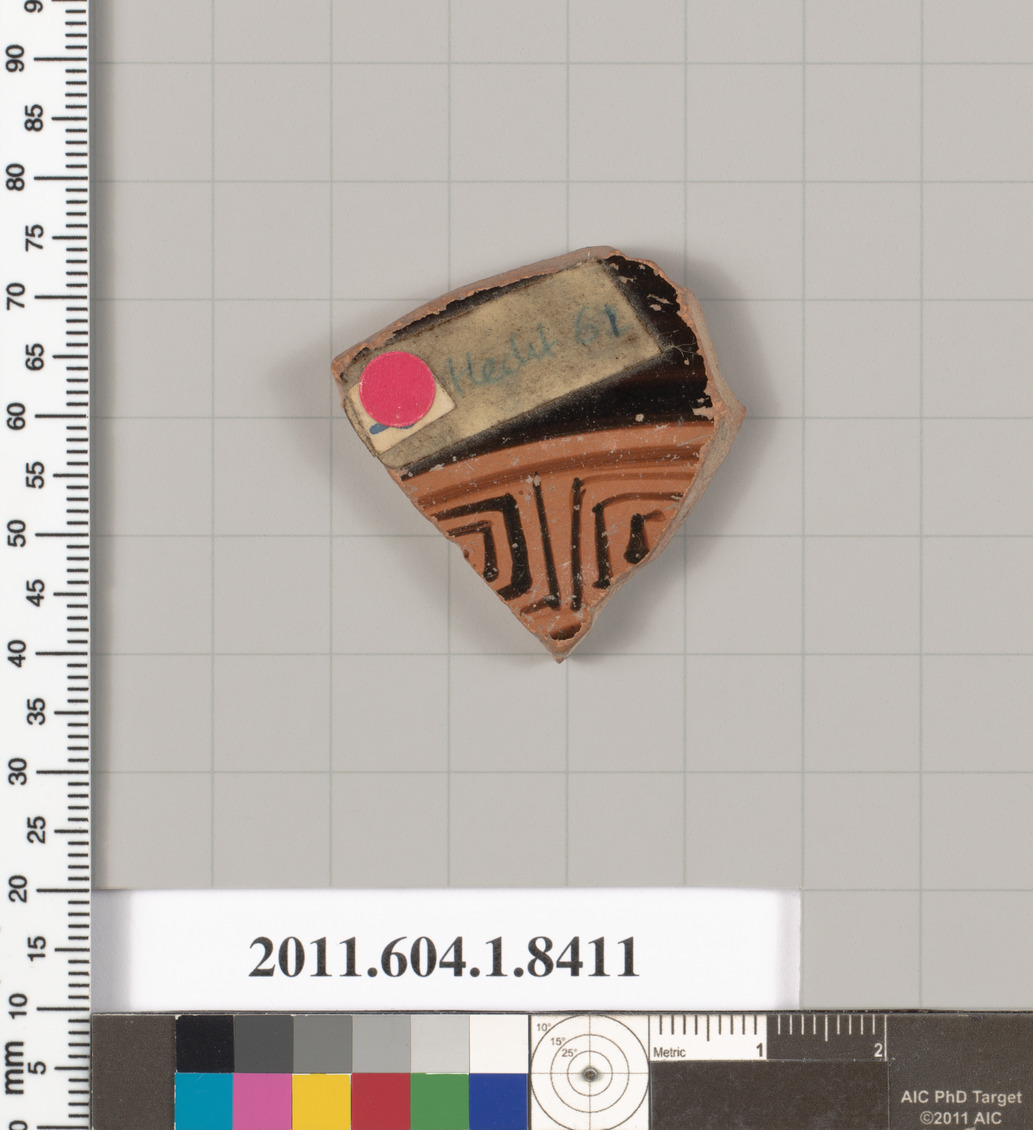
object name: kylix fragment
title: Terracotta fragment of a kylix (drinking cup)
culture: greek, attic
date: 400-351 BCE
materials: terracotta